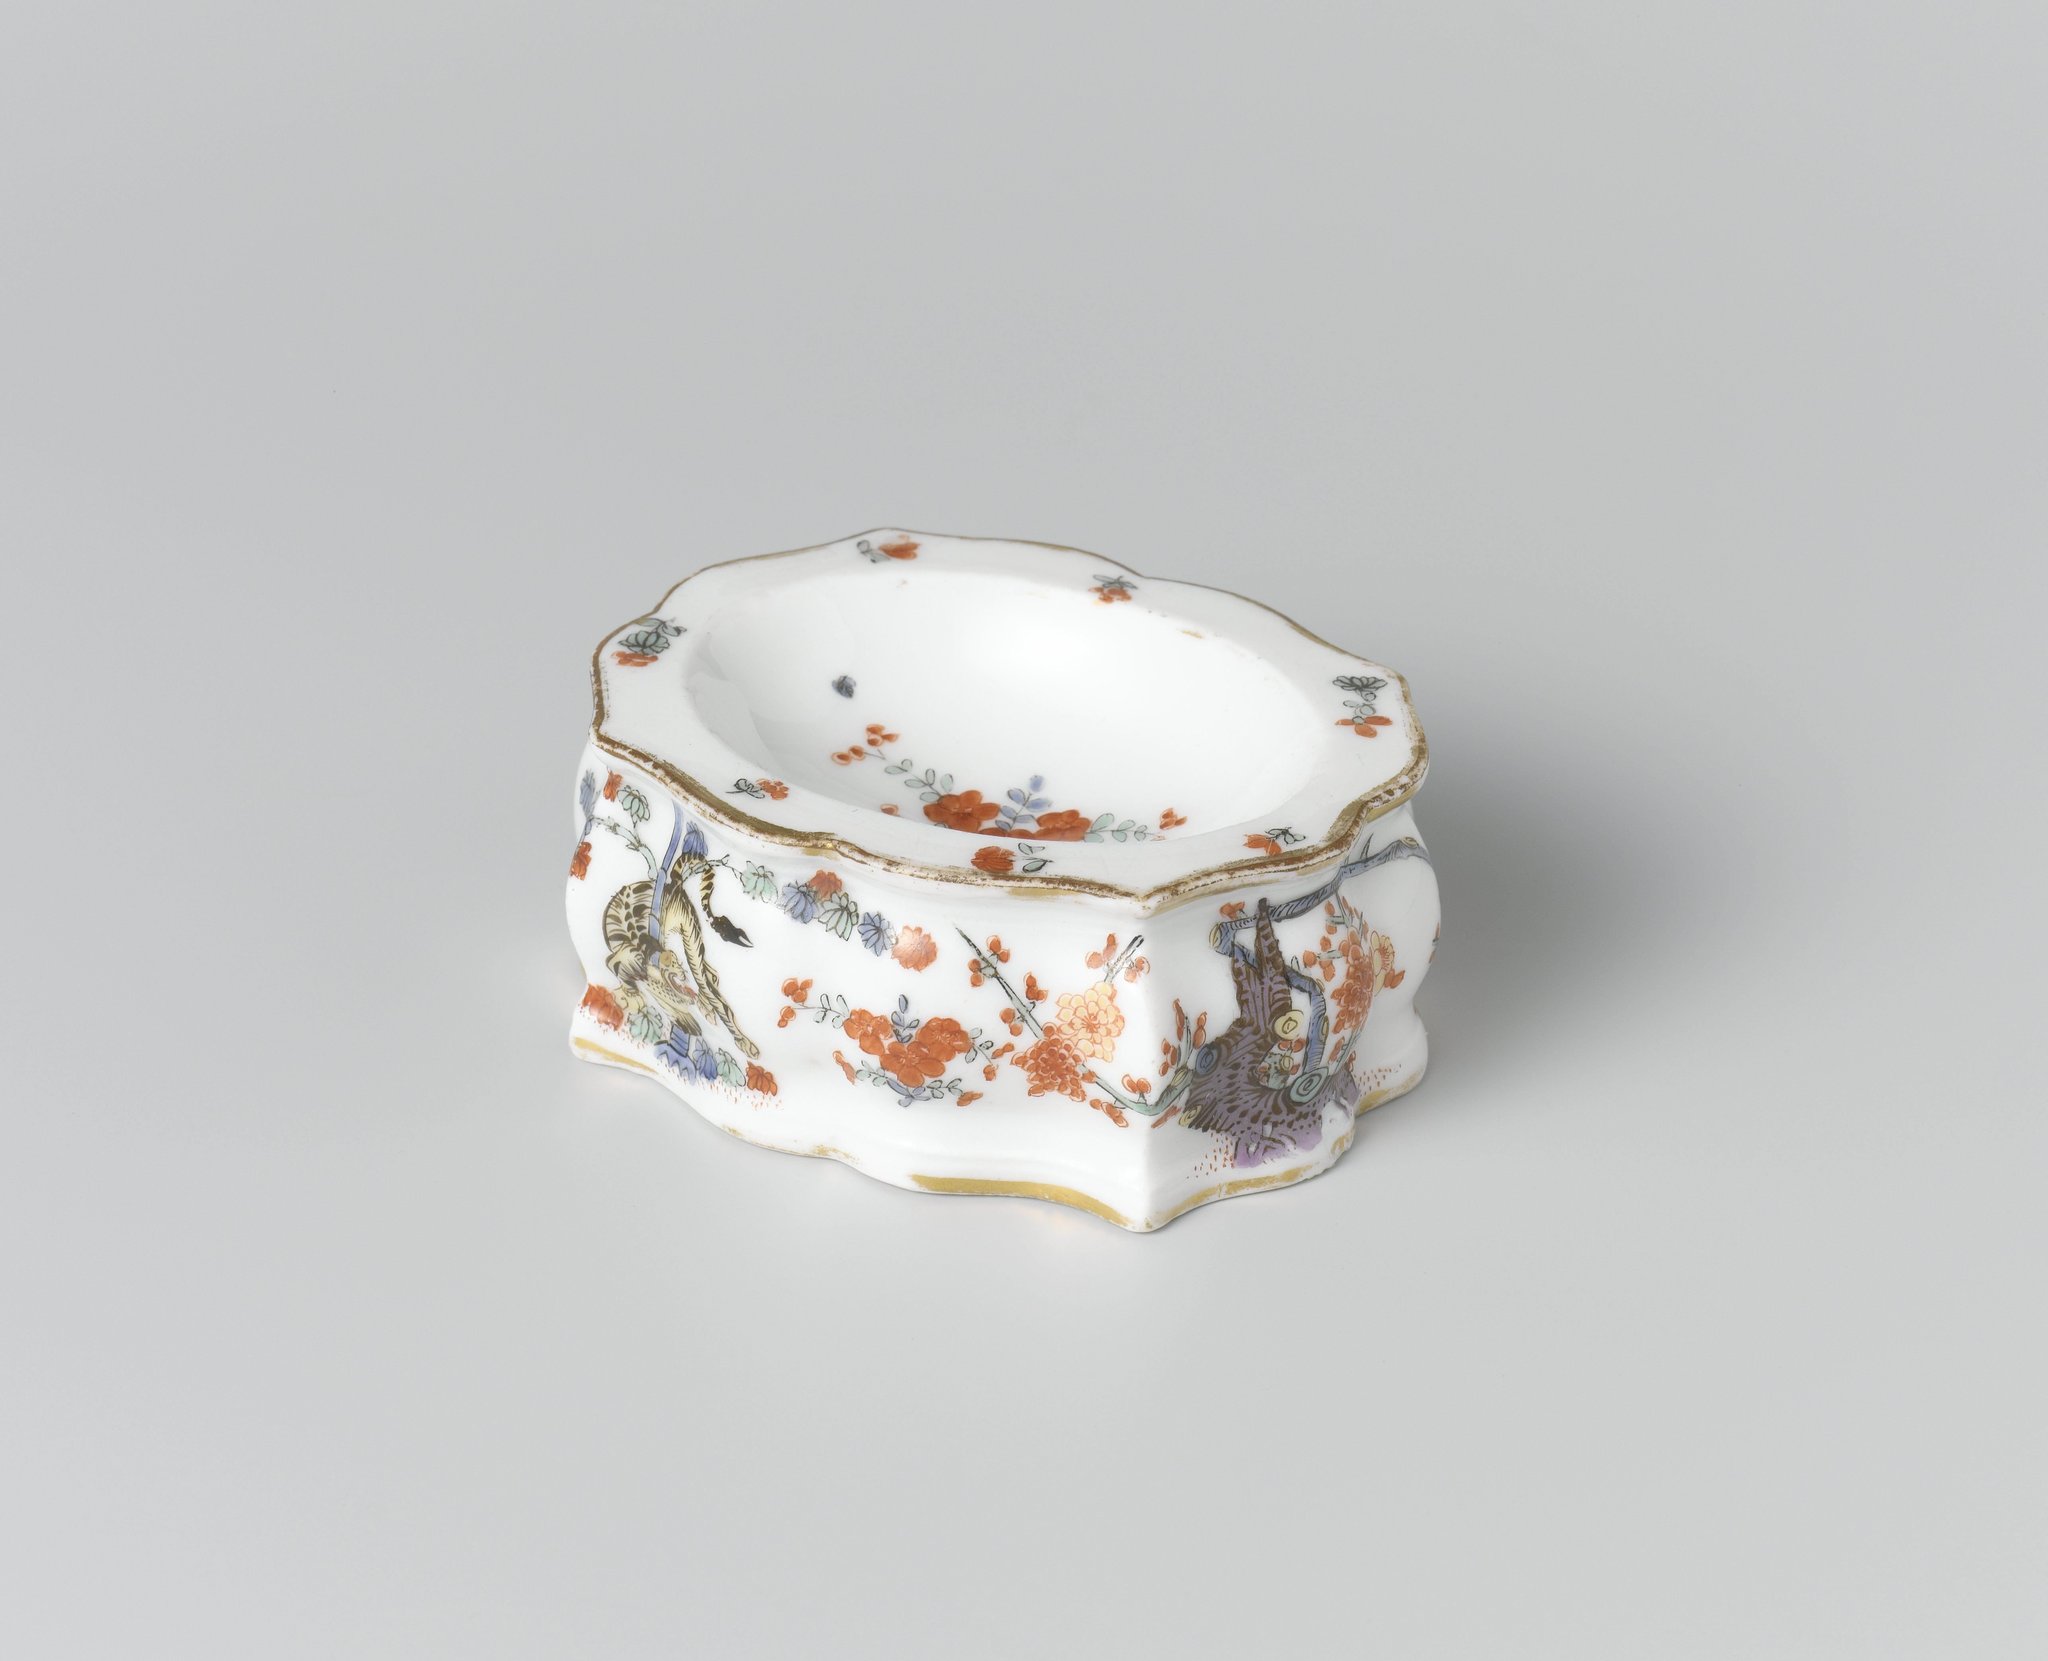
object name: salt condiment vessel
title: Zoutvat, veelkleurig beschilderd met een Kakiemon-decor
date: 1740-1745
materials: porcelain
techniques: painted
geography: meissen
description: Zoutvat van beschilderd porselein. Het zoutvat is rechthoekig en heeft accoladevormige gewelfde wanden. Het zoutvat is versierd met een boomstronk in violet, waaraan takken met bloemen in kakiemon-stijl en met een tijger om een bamboestengel.